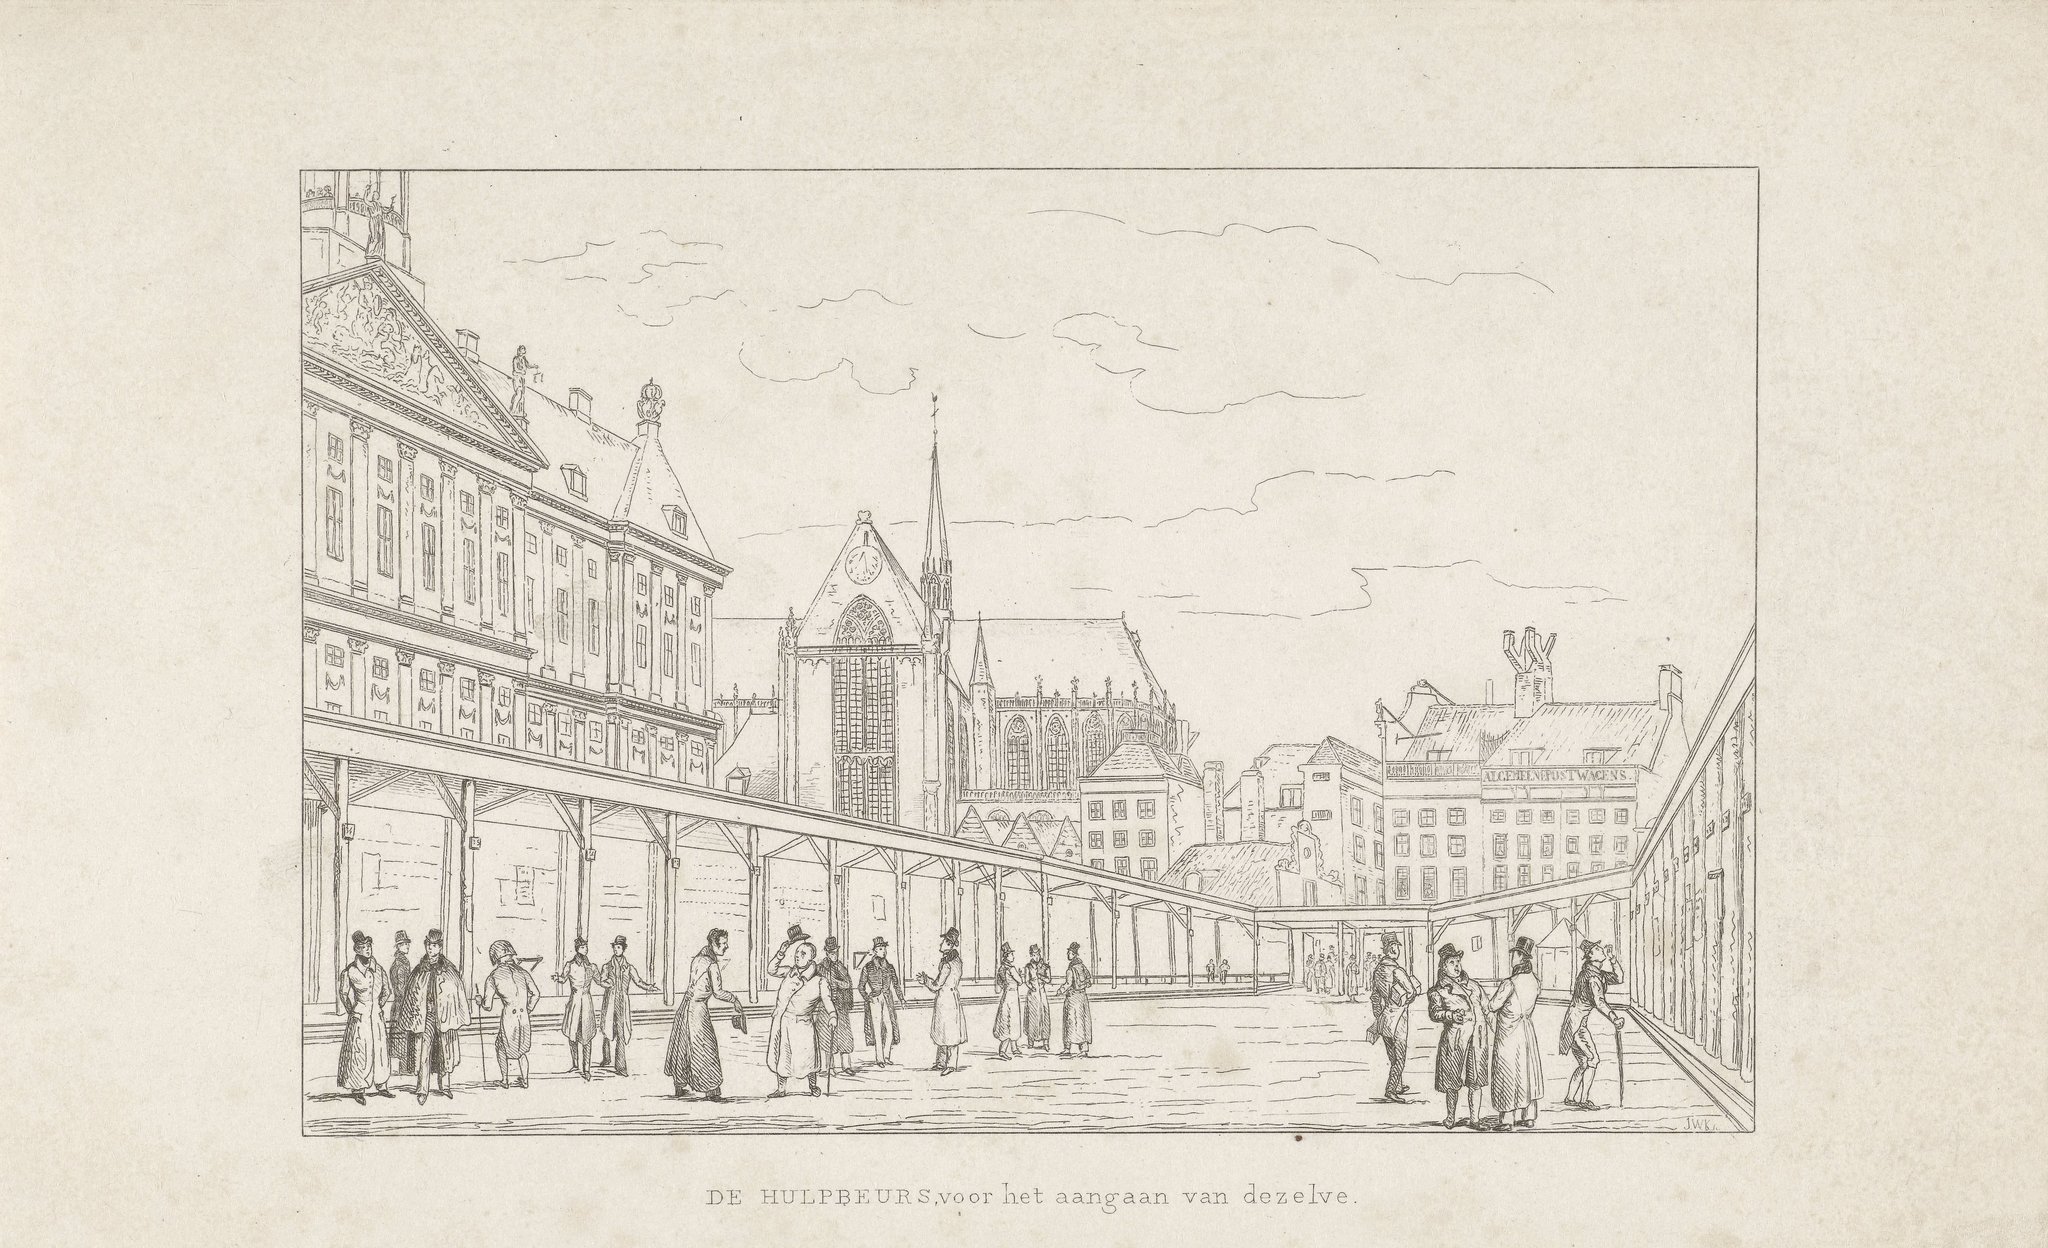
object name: print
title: Gezicht op de hulpbeurs op de Dam te Amsterdam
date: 1836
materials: paper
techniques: etching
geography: amsterdam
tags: stock exchange, stock-market, church (exterior), square, place, circus, etc. (+ city(-scape) with figures, staffage), royal palace of amsterdam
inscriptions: collector's mark: Lugt 2228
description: De hulpbeurs op de Dam in Amsterdam van binnen gezien. De houten hulpbeurs werd gebruikt van 12 januari 1836 tot 10 september 1845, tussen het afbreken van de oude beurs en het inwijden van de nieuwe beurs.